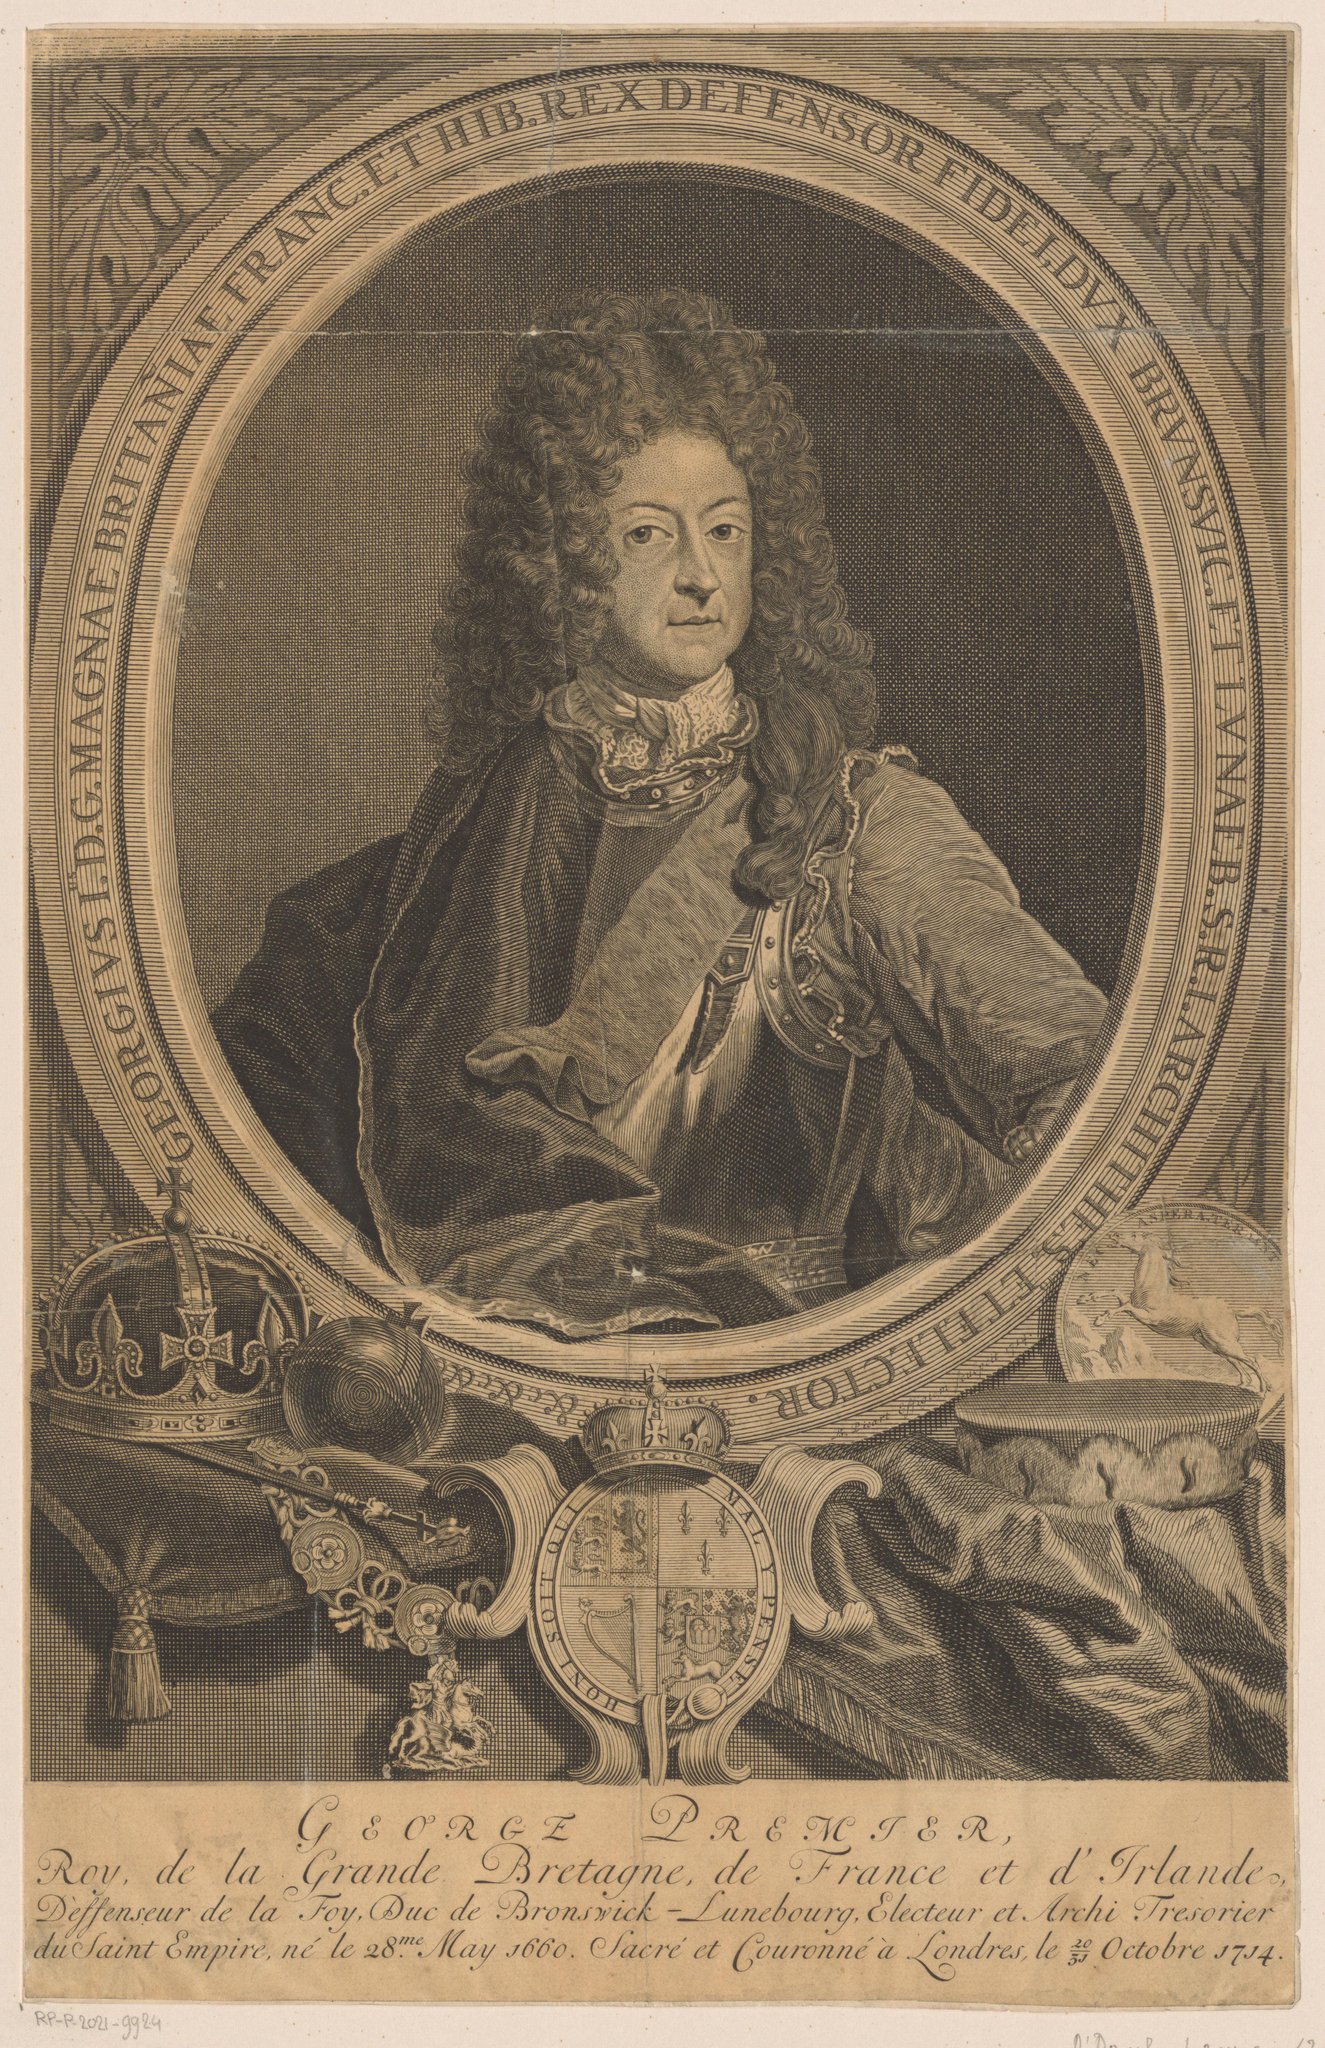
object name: print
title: Portret van George I, koning van Groot-Brittannië en Ierland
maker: Anonymous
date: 1714-1799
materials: paper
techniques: engraving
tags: george i (koning van groot-brittannië en ierland), historical persons, armorial bearing, heraldry, insignia and symbols of sovereignty (crown, diadem, sceptre, orb, seal, standard, cloak, pectoral)